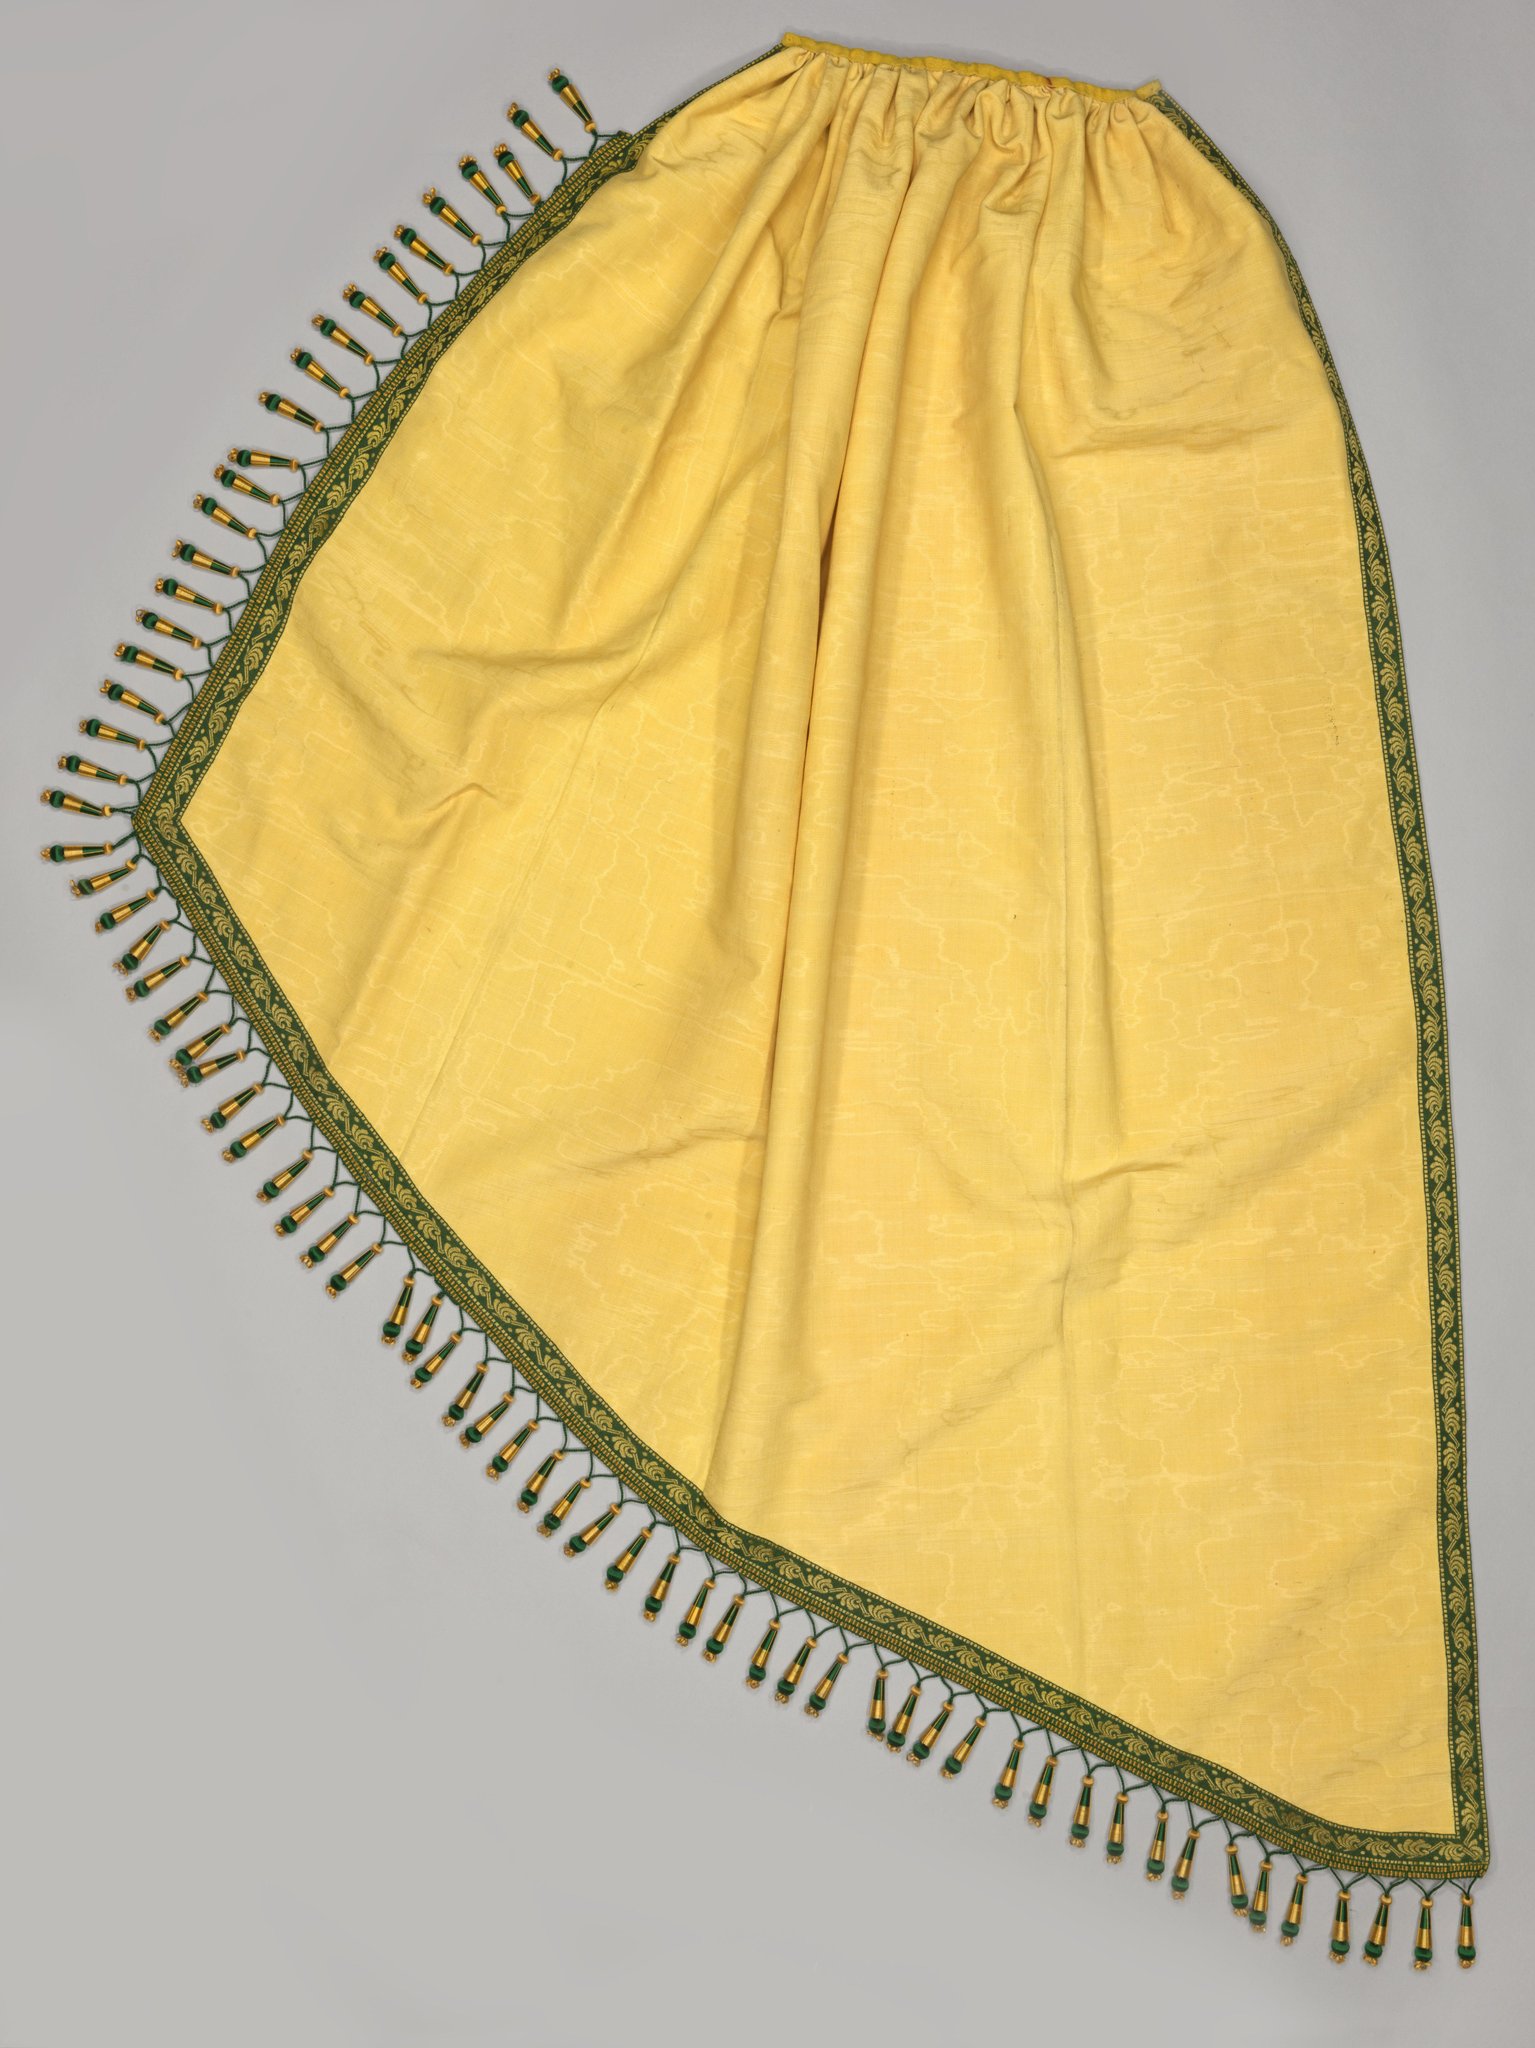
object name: bed covering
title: Hoekkap van een bedgarnituur van gele gewaterde wol met groen passement en afhangende klosjes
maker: Anonymous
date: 1795-1815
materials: silk, wool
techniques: moire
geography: northern netherlands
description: Een hoekkap voor bovenaan een gordijnstok, behorend bij bedgarnituur van gele gewaterde wol, omboord met groen passement met een geel motief en met een groen en geel boordsel met afhangende klosjes die met gele en groene zijde zijn omwonden.